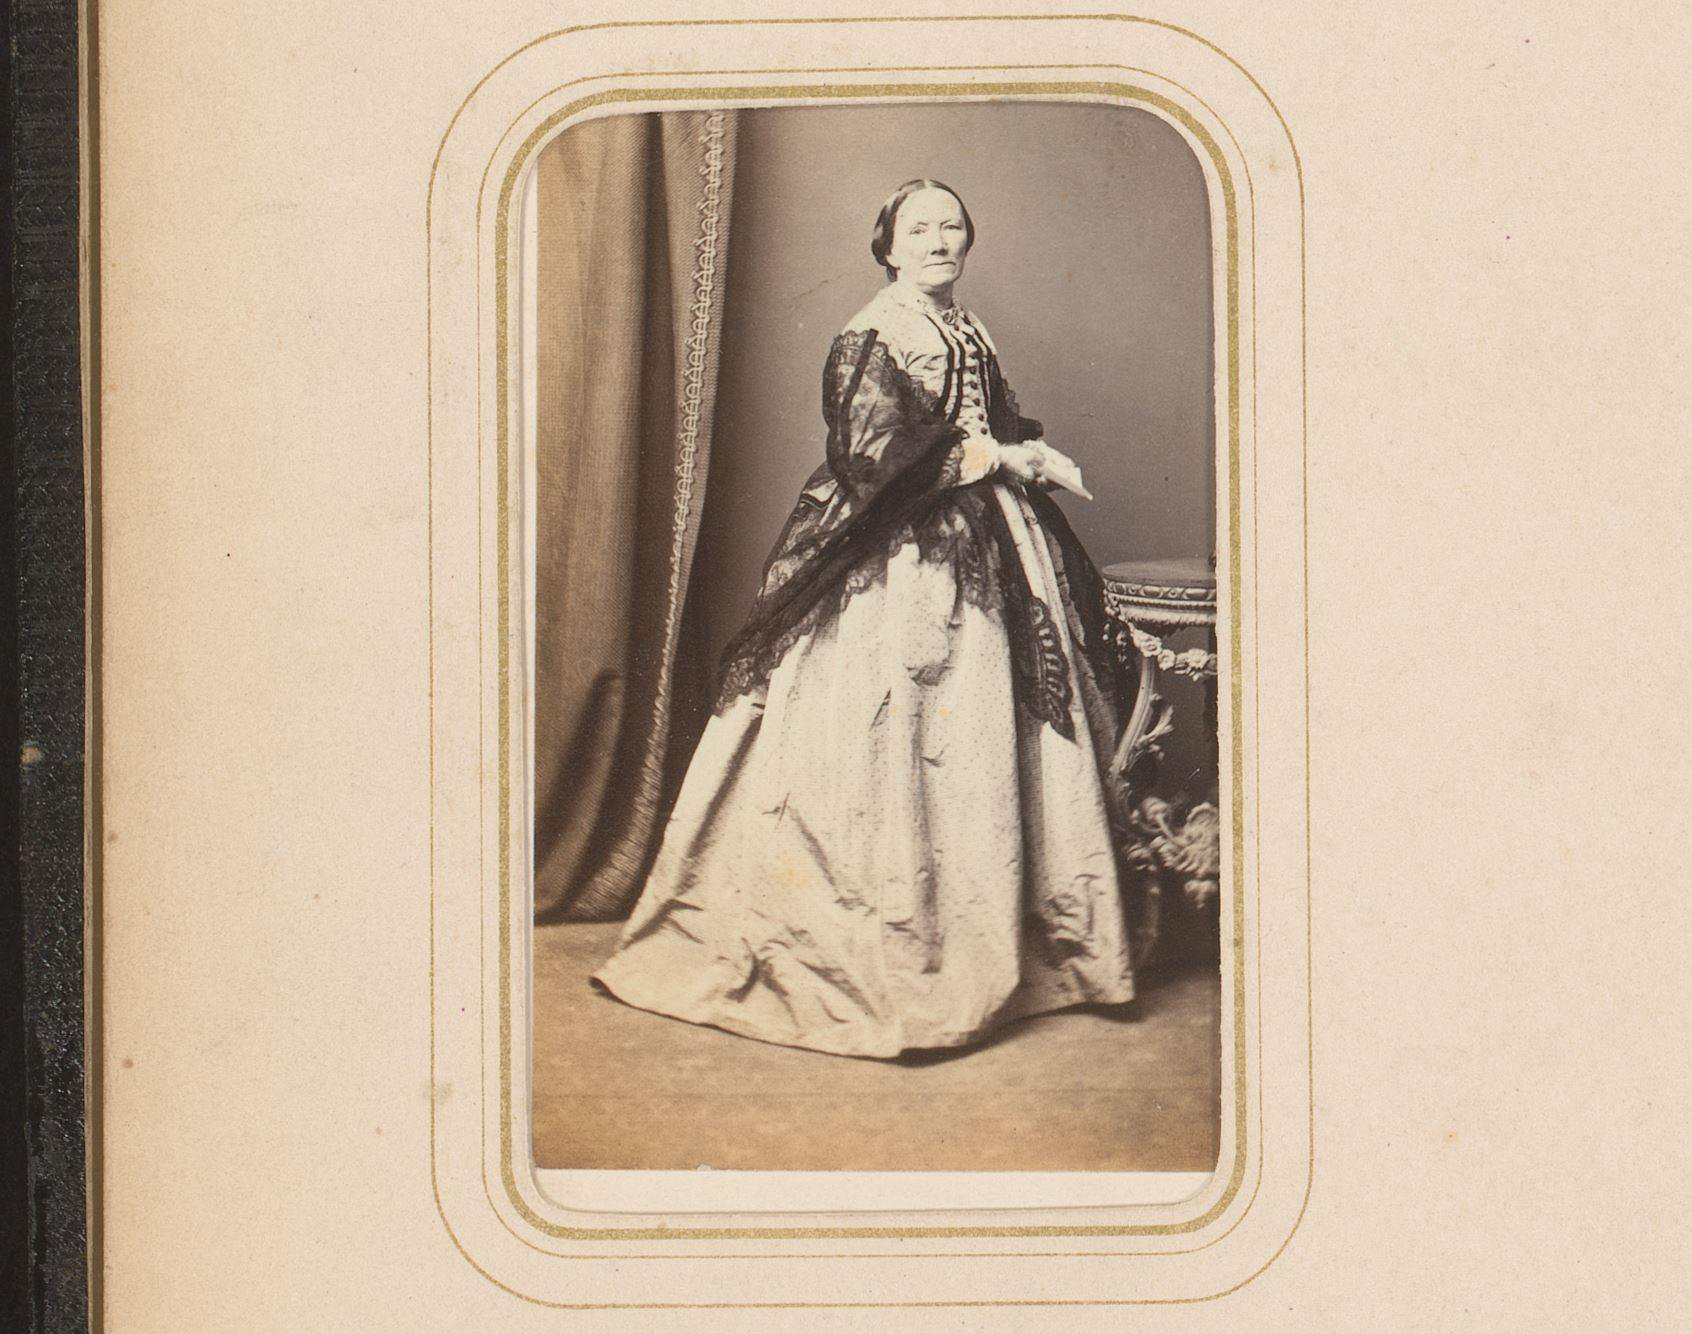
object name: carte de visite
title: Portret van een staande vrouw met waaier in de hand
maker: o.c. smith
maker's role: fotograaf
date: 1860-1900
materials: cardboard, photographic support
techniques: albumen print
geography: stroud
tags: historical persons - bb - woman, fan, standing figure - aa - female human figure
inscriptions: inscription: ‘O. C. SMITH/ LANDSDOWN/ STROUD/ NEGATIVES KEPT - COPIES CAN ALWAYS BE HAD’